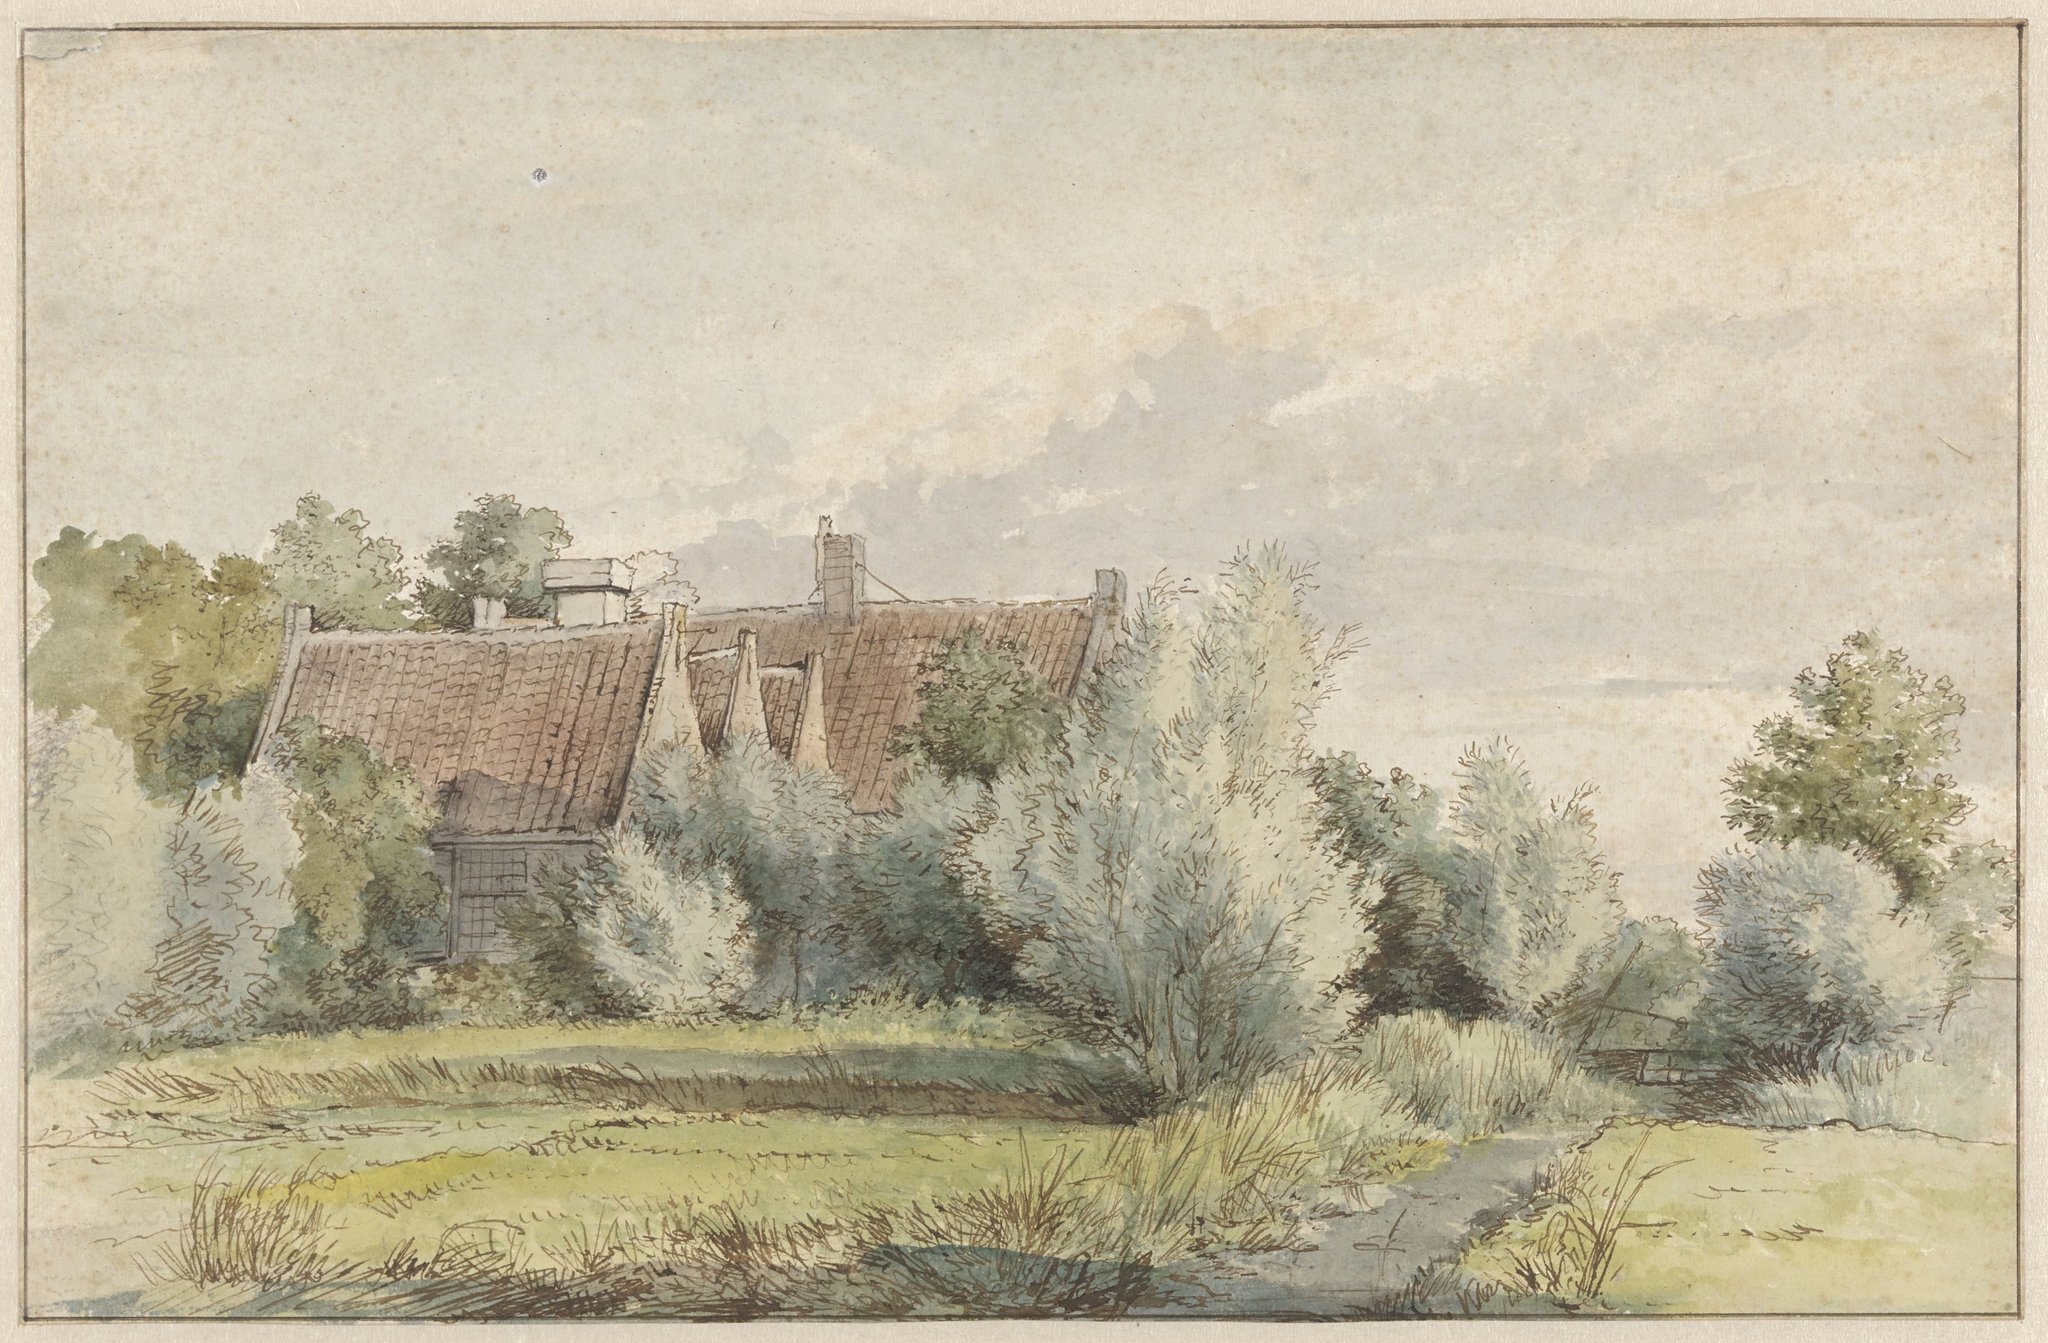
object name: watercolor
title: Huis tussen bomen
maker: arnoldus johannes eymer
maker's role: draughtsman, print maker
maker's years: 1803-1863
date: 1813-1863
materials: ink, paper, pencil, watercolor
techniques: brush, pen